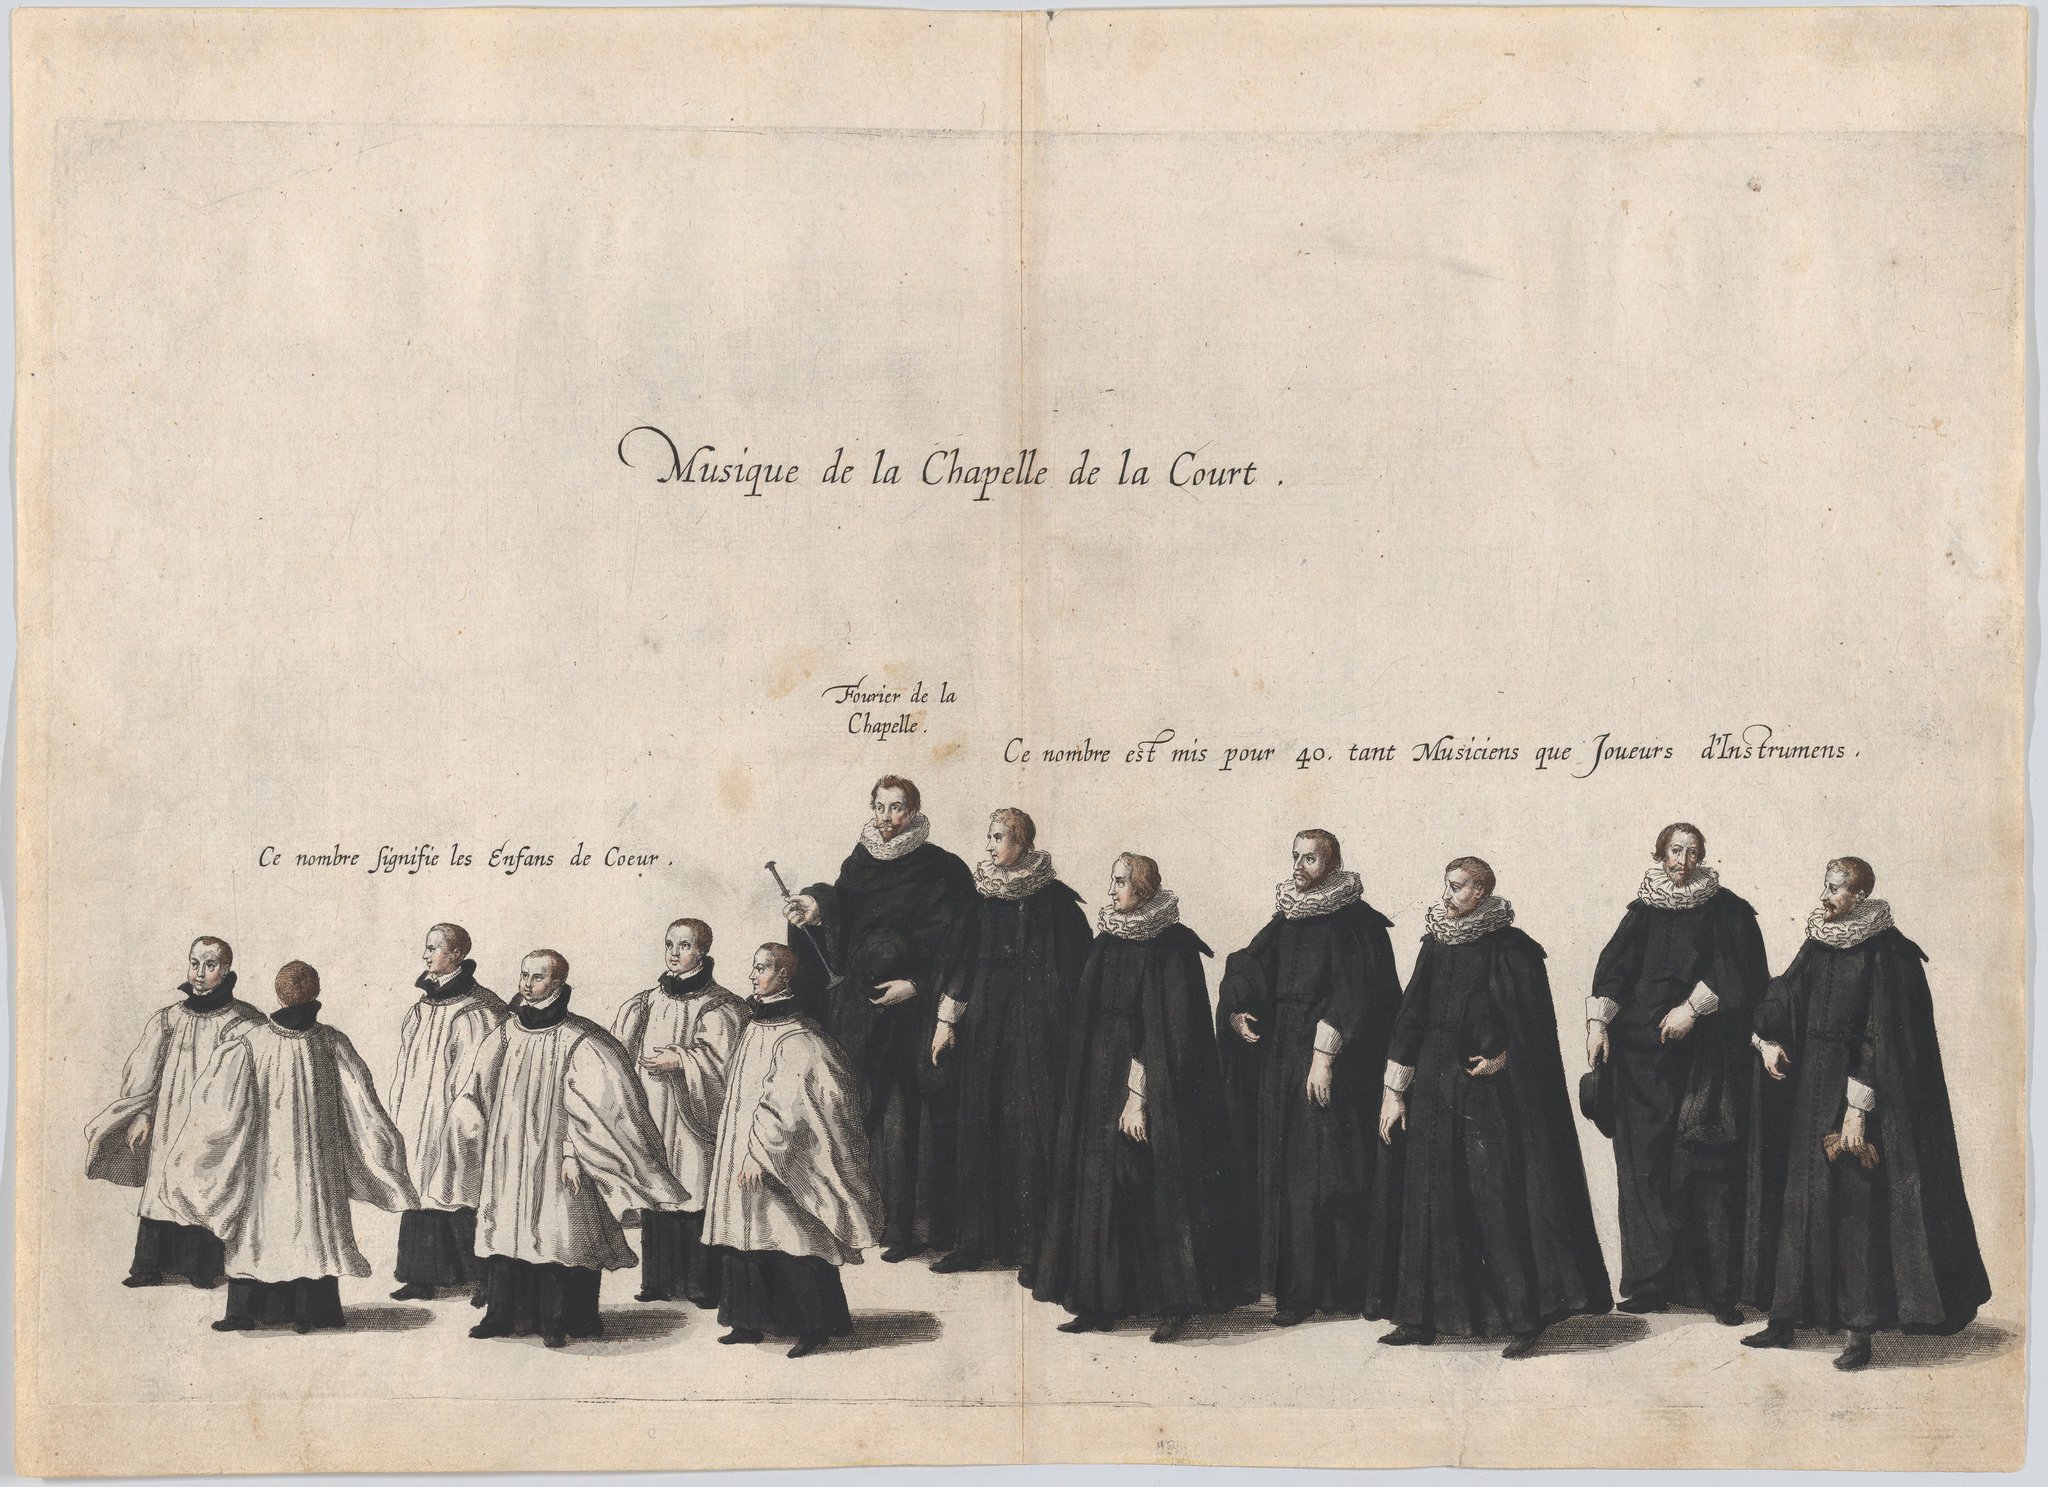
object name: print, fete, ornament architecture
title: Plate 6: Members of the court chapel choir marching in the funeral procession of Archduke Albert of Austria; from 'Pompa Funebris ... Alberti Pii'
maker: cornelis galle (i)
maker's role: artist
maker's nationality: netherlandish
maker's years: 1576-1650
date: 1623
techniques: etching, hand coloring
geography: brussels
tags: men